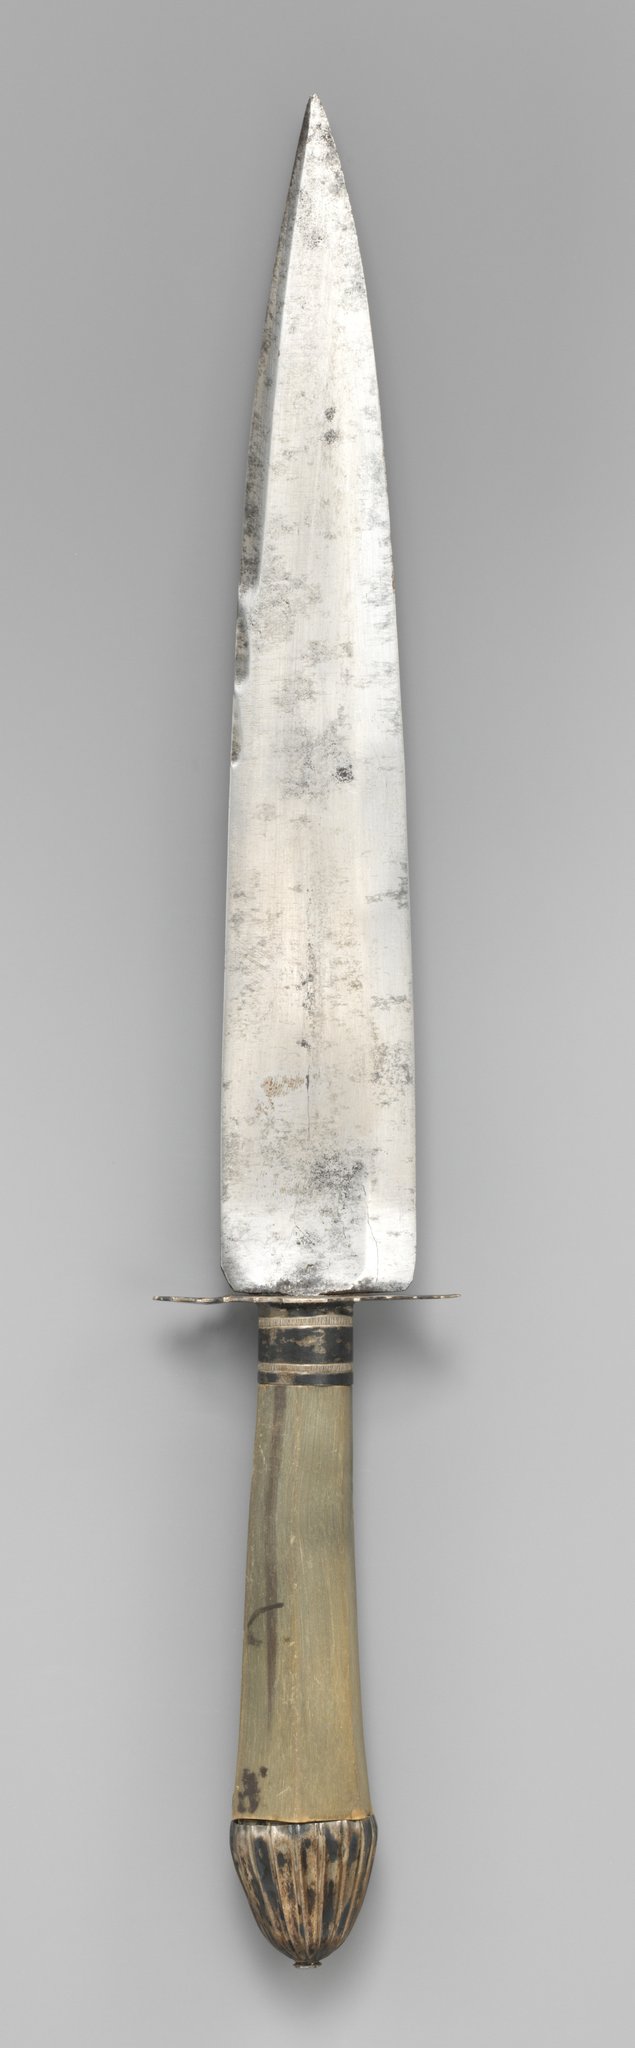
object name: huntsman's knife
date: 1701-1800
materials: horn, silver, steel